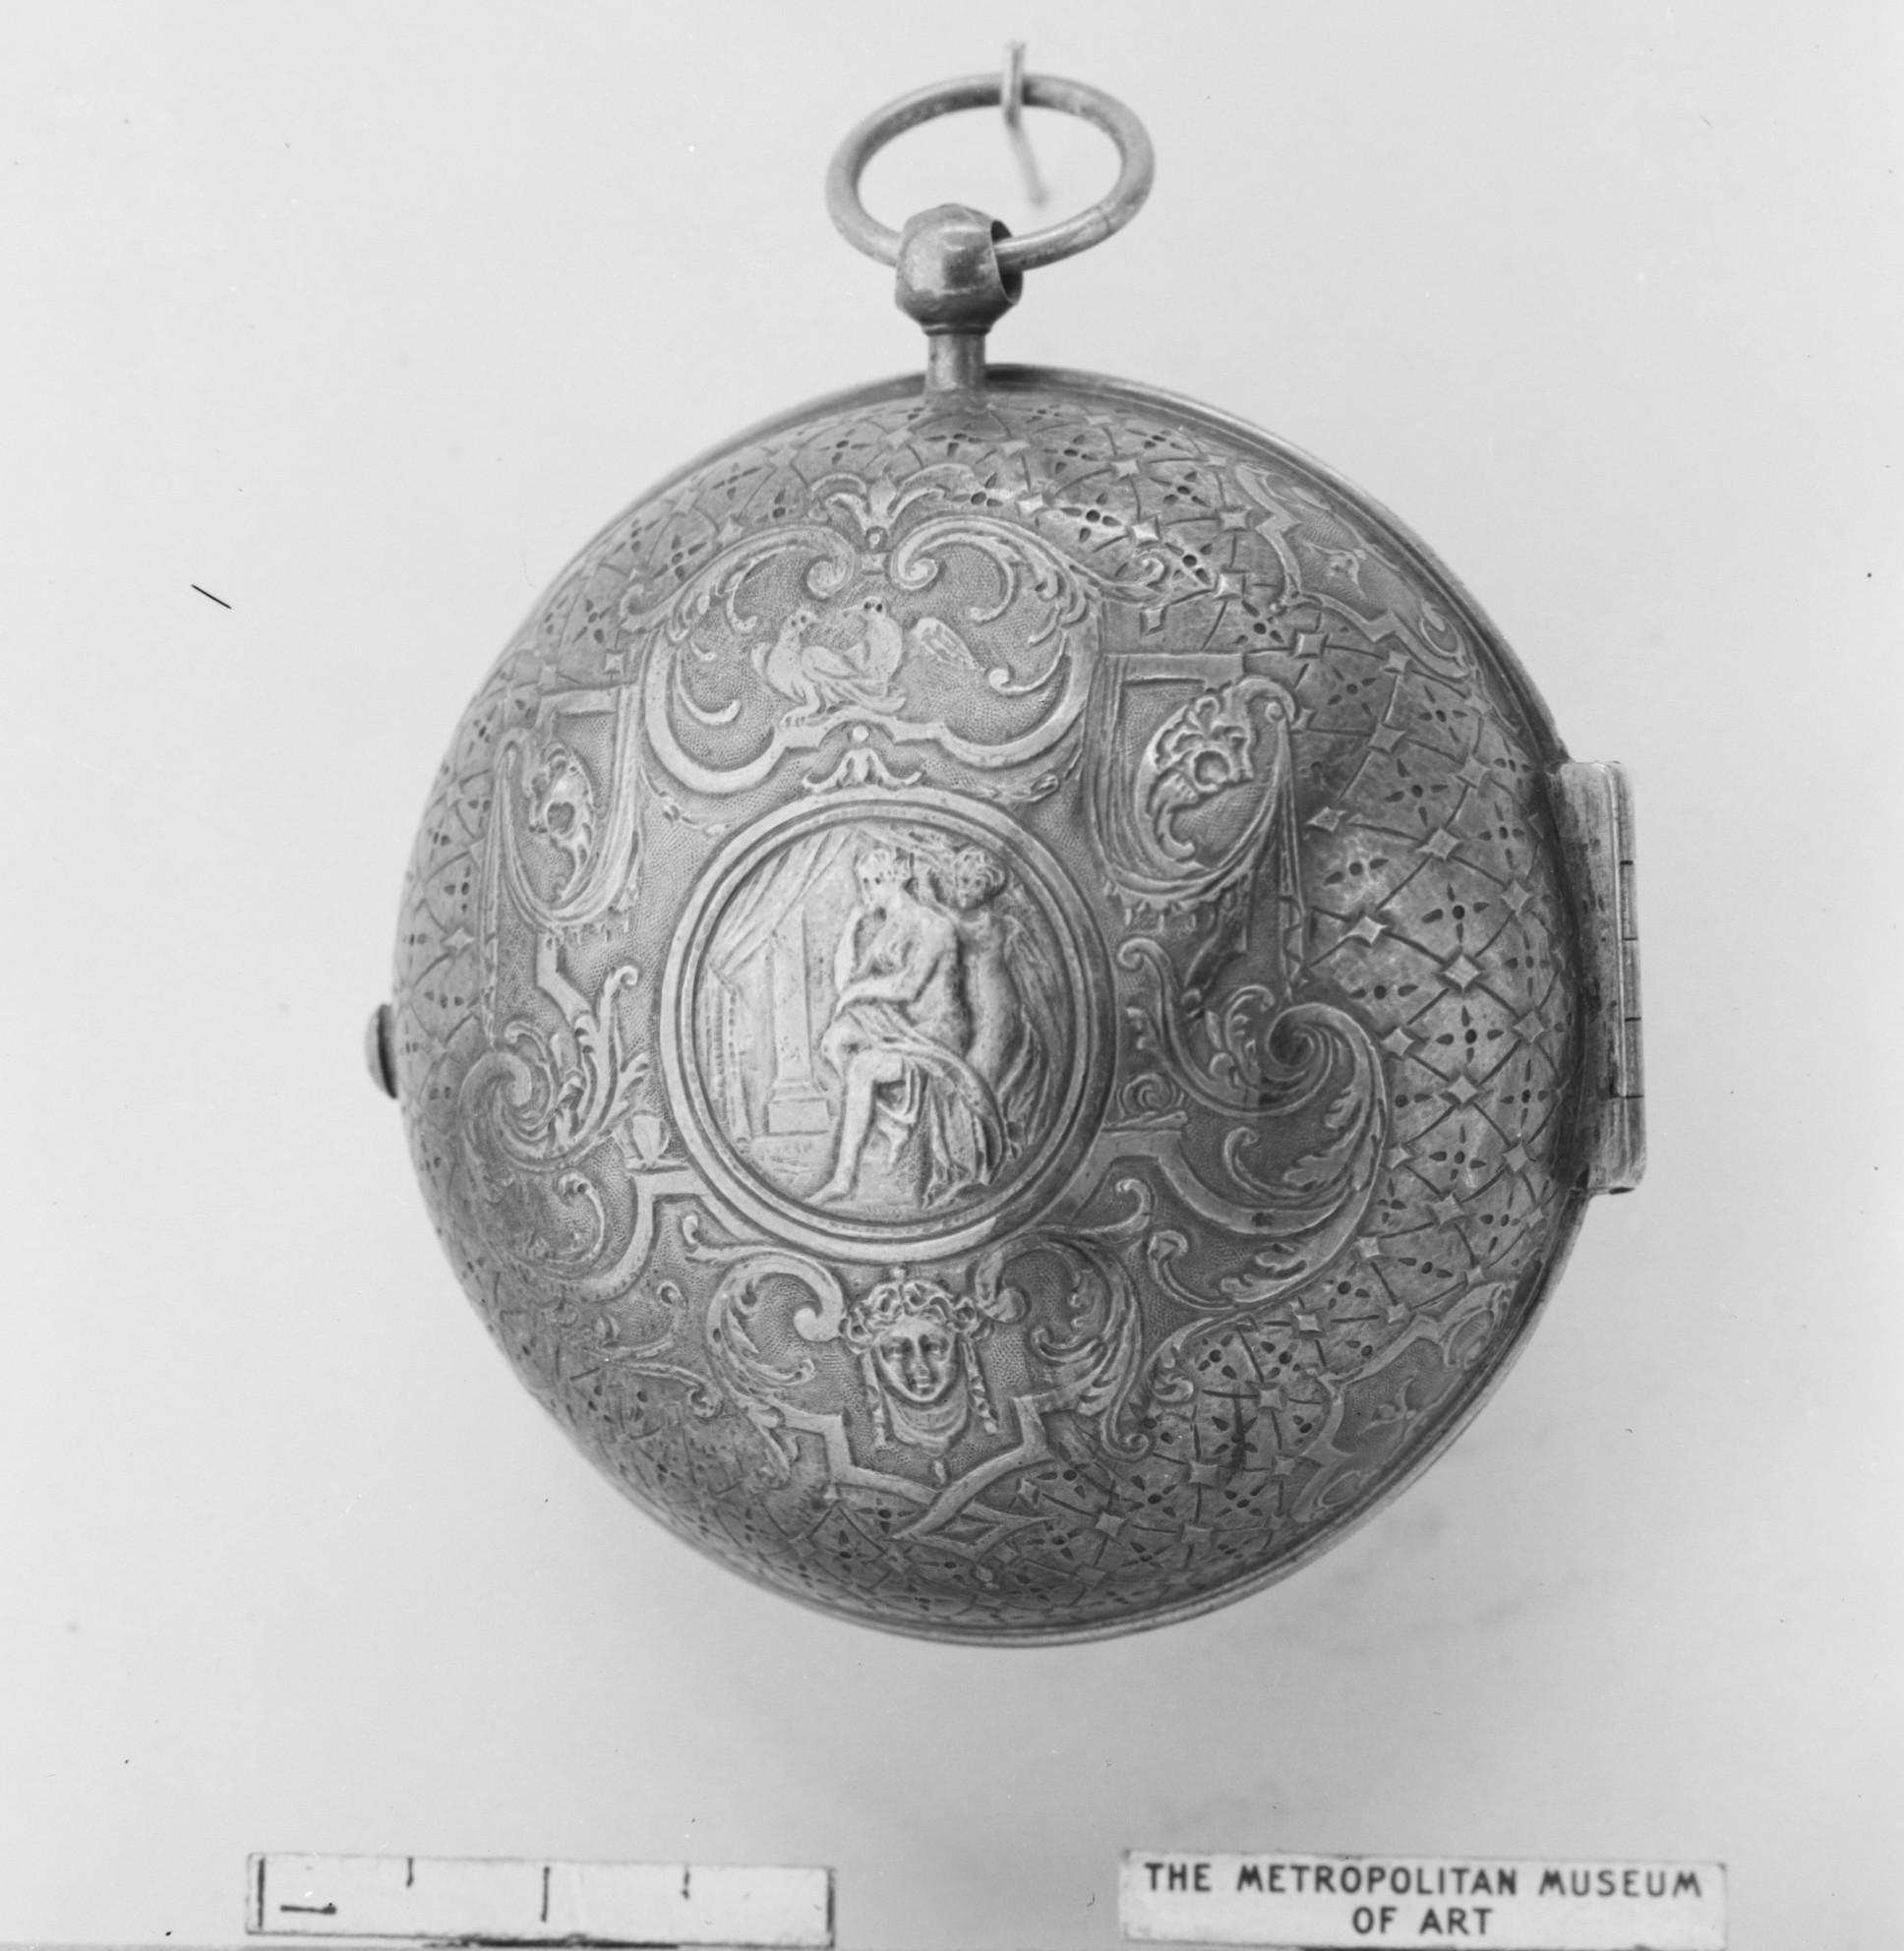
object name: watch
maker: abel durade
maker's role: maker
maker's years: 1770-1815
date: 1770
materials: enamel, silver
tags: birds,faces,male nudes,female nudes